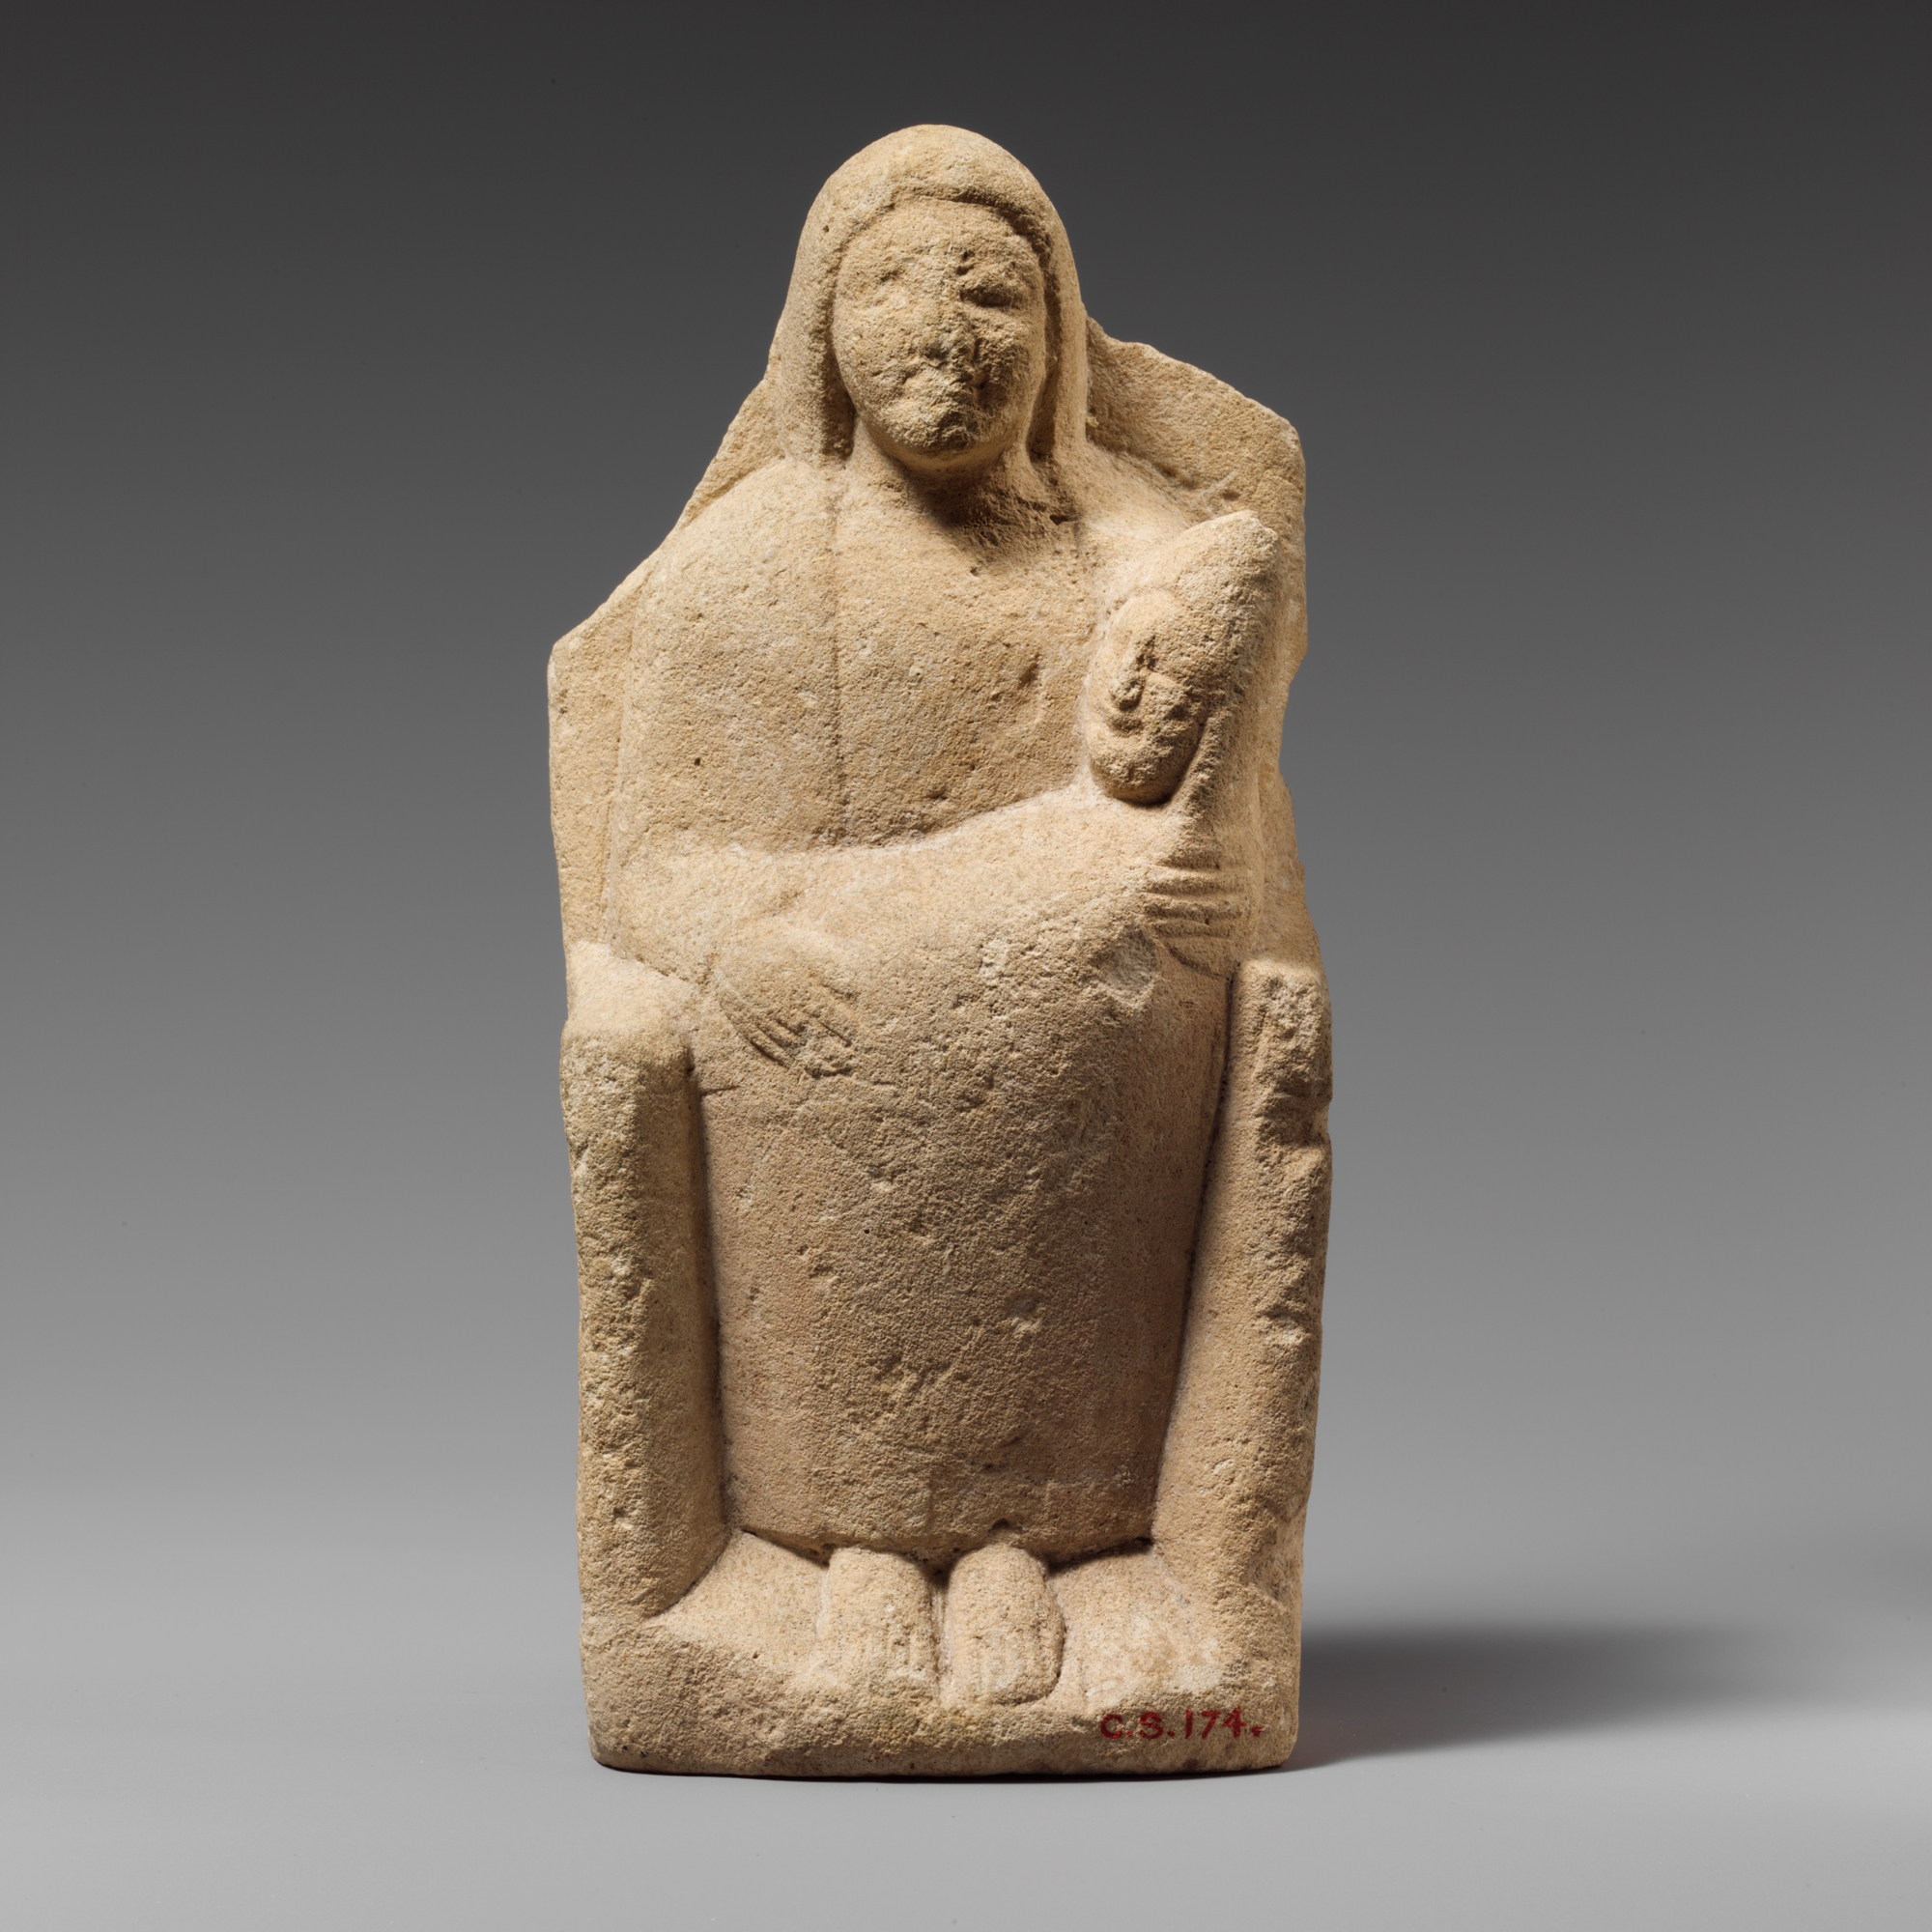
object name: statuette of a woman nursing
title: Seated limestone kourotrophos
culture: cypriot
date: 534-468 BCE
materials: limestone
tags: infants,women